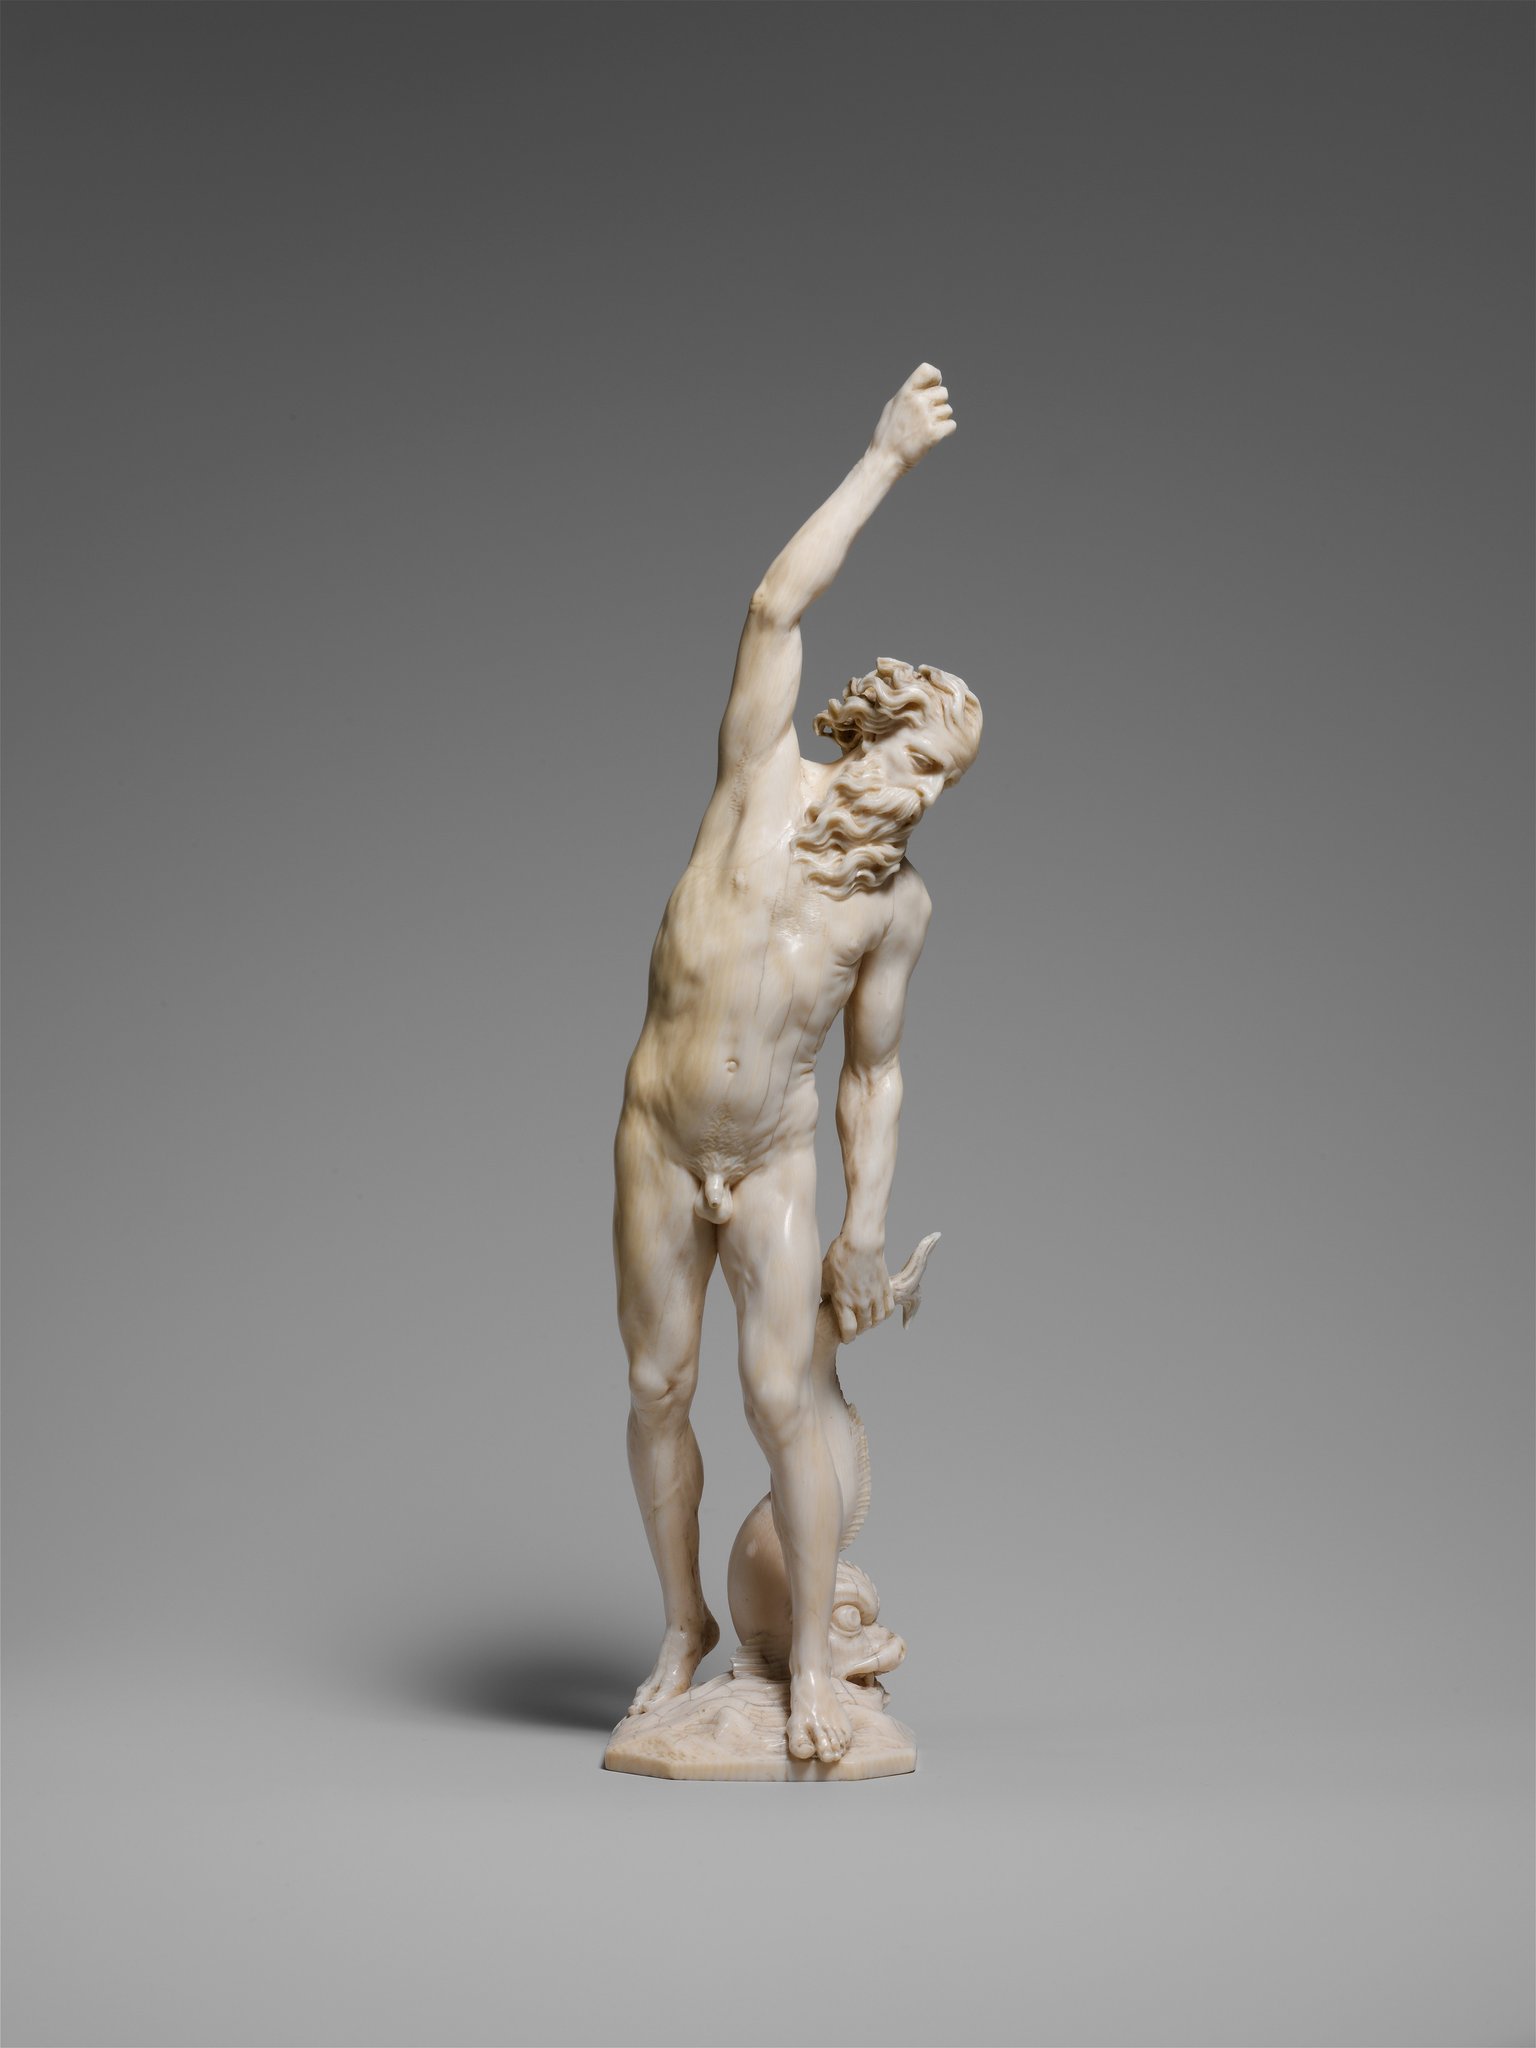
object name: statuette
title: Neptune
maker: adam lenckhart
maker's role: artist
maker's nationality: german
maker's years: 1610-1661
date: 1634-1666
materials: ivory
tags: male nudes,neptune,dolphins